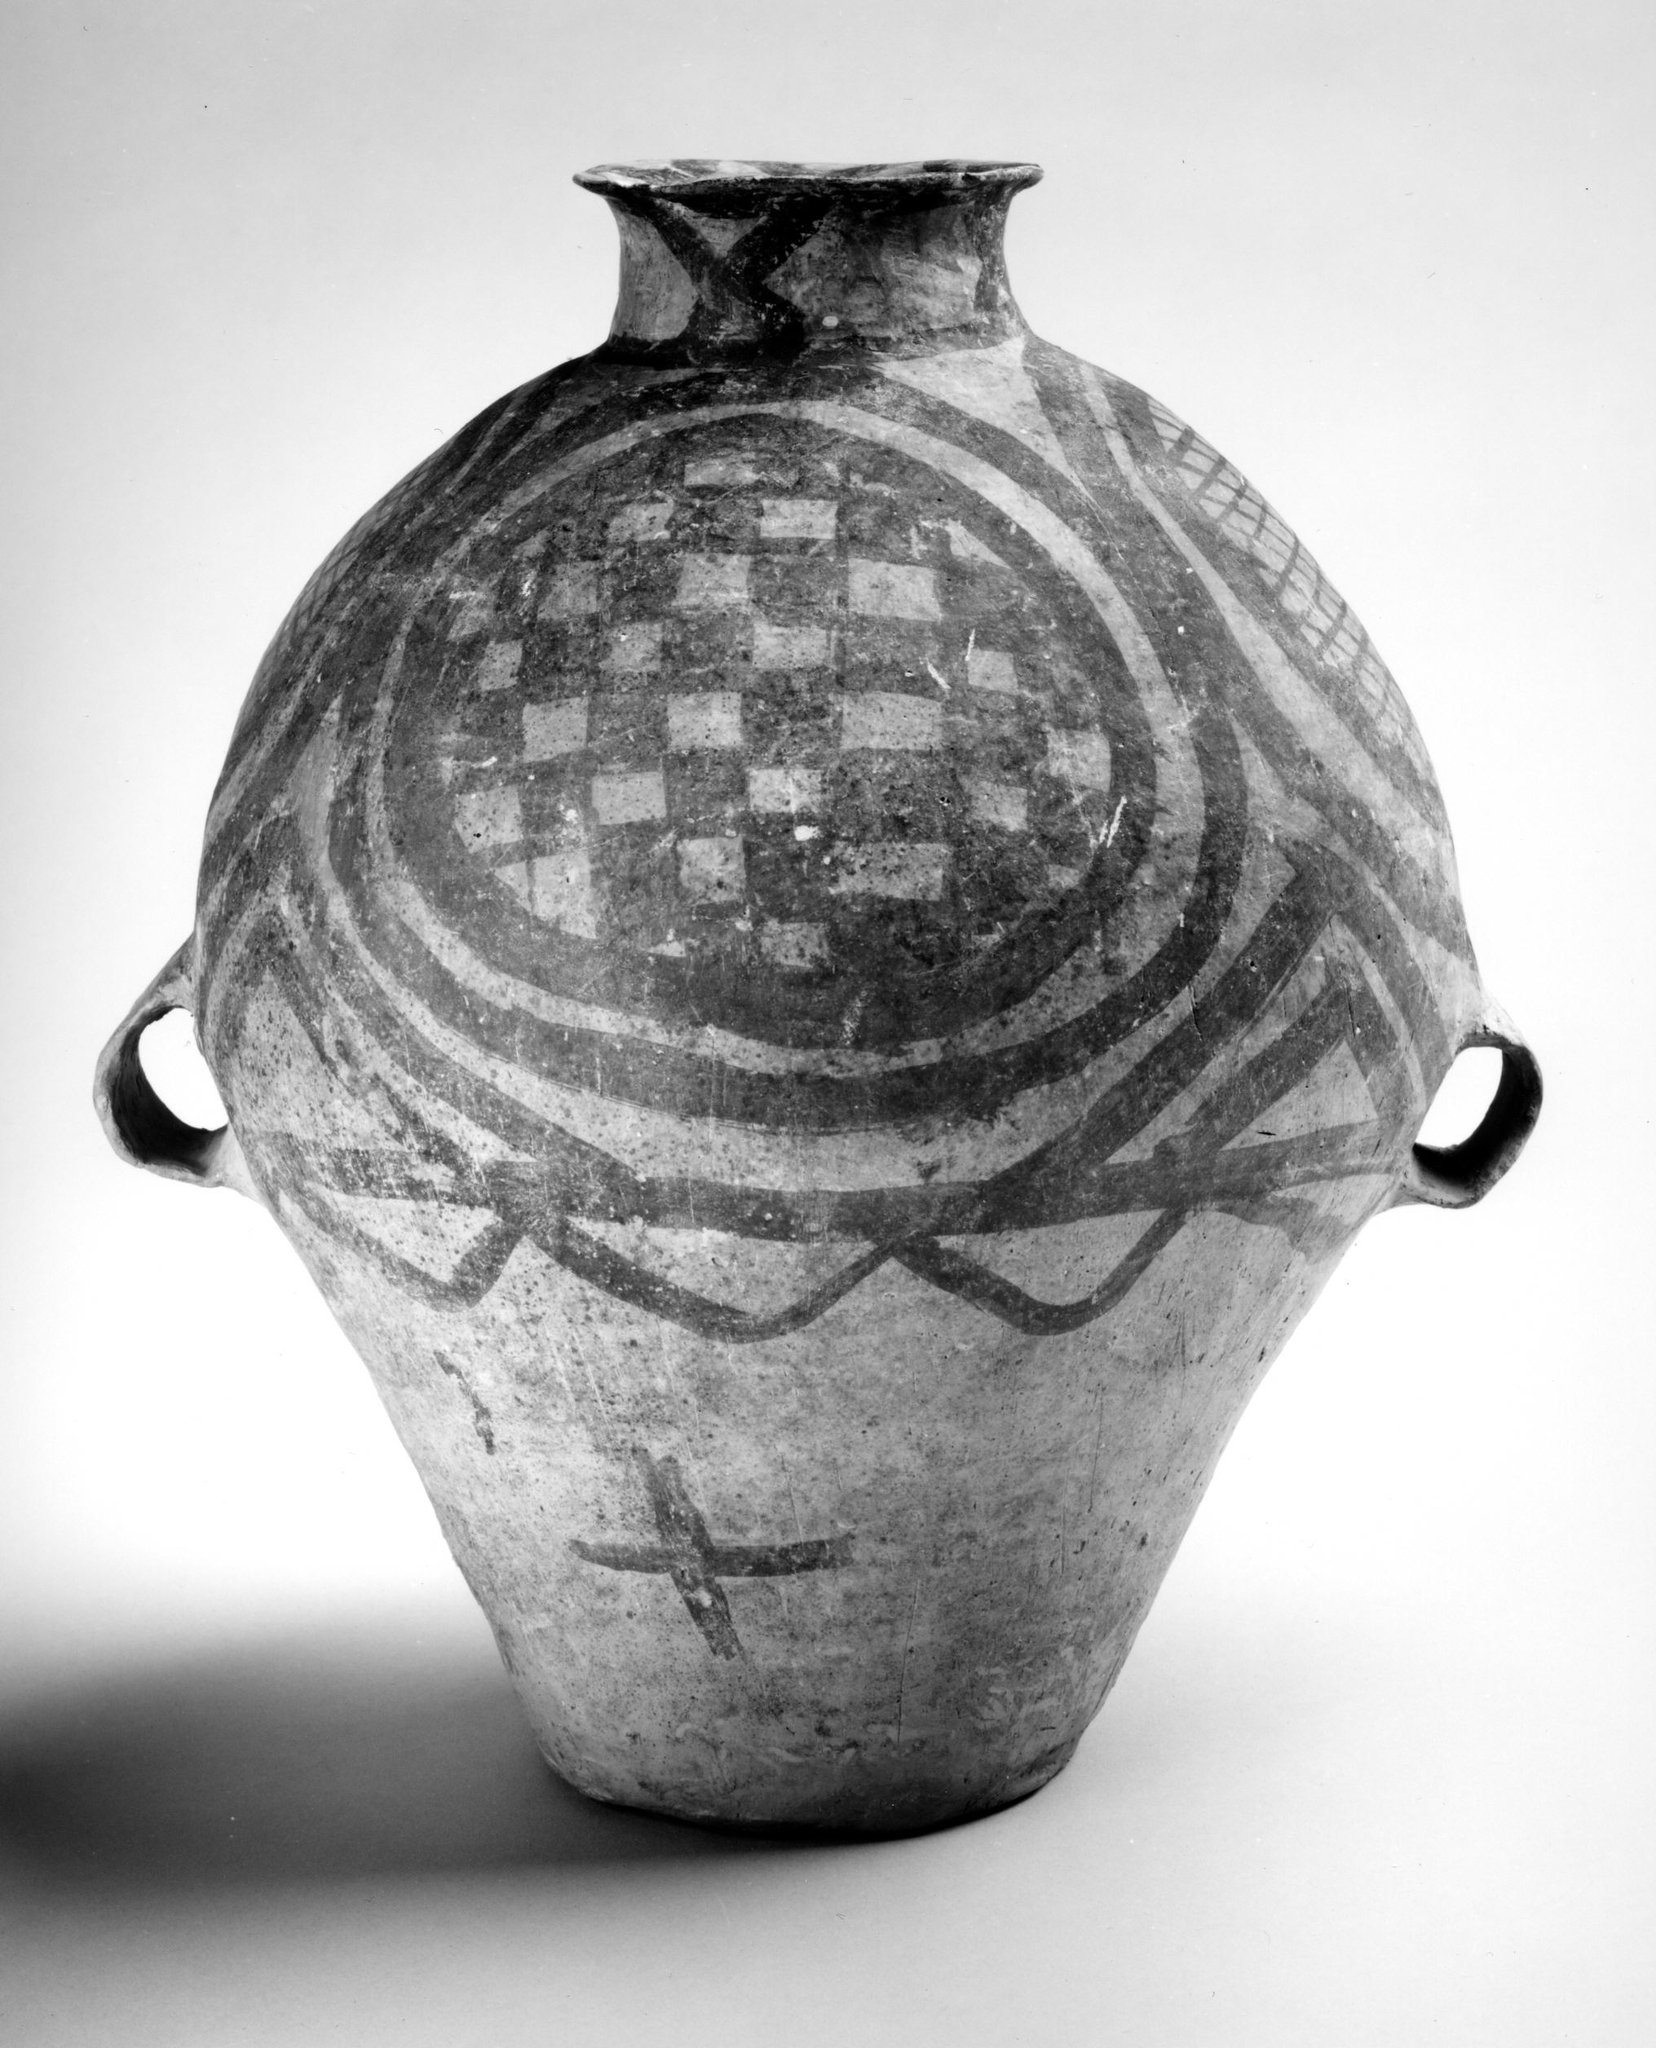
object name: jar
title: Ovoid Jar (Hu)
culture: chinese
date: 2300-2000 BCE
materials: earthenware, pigment